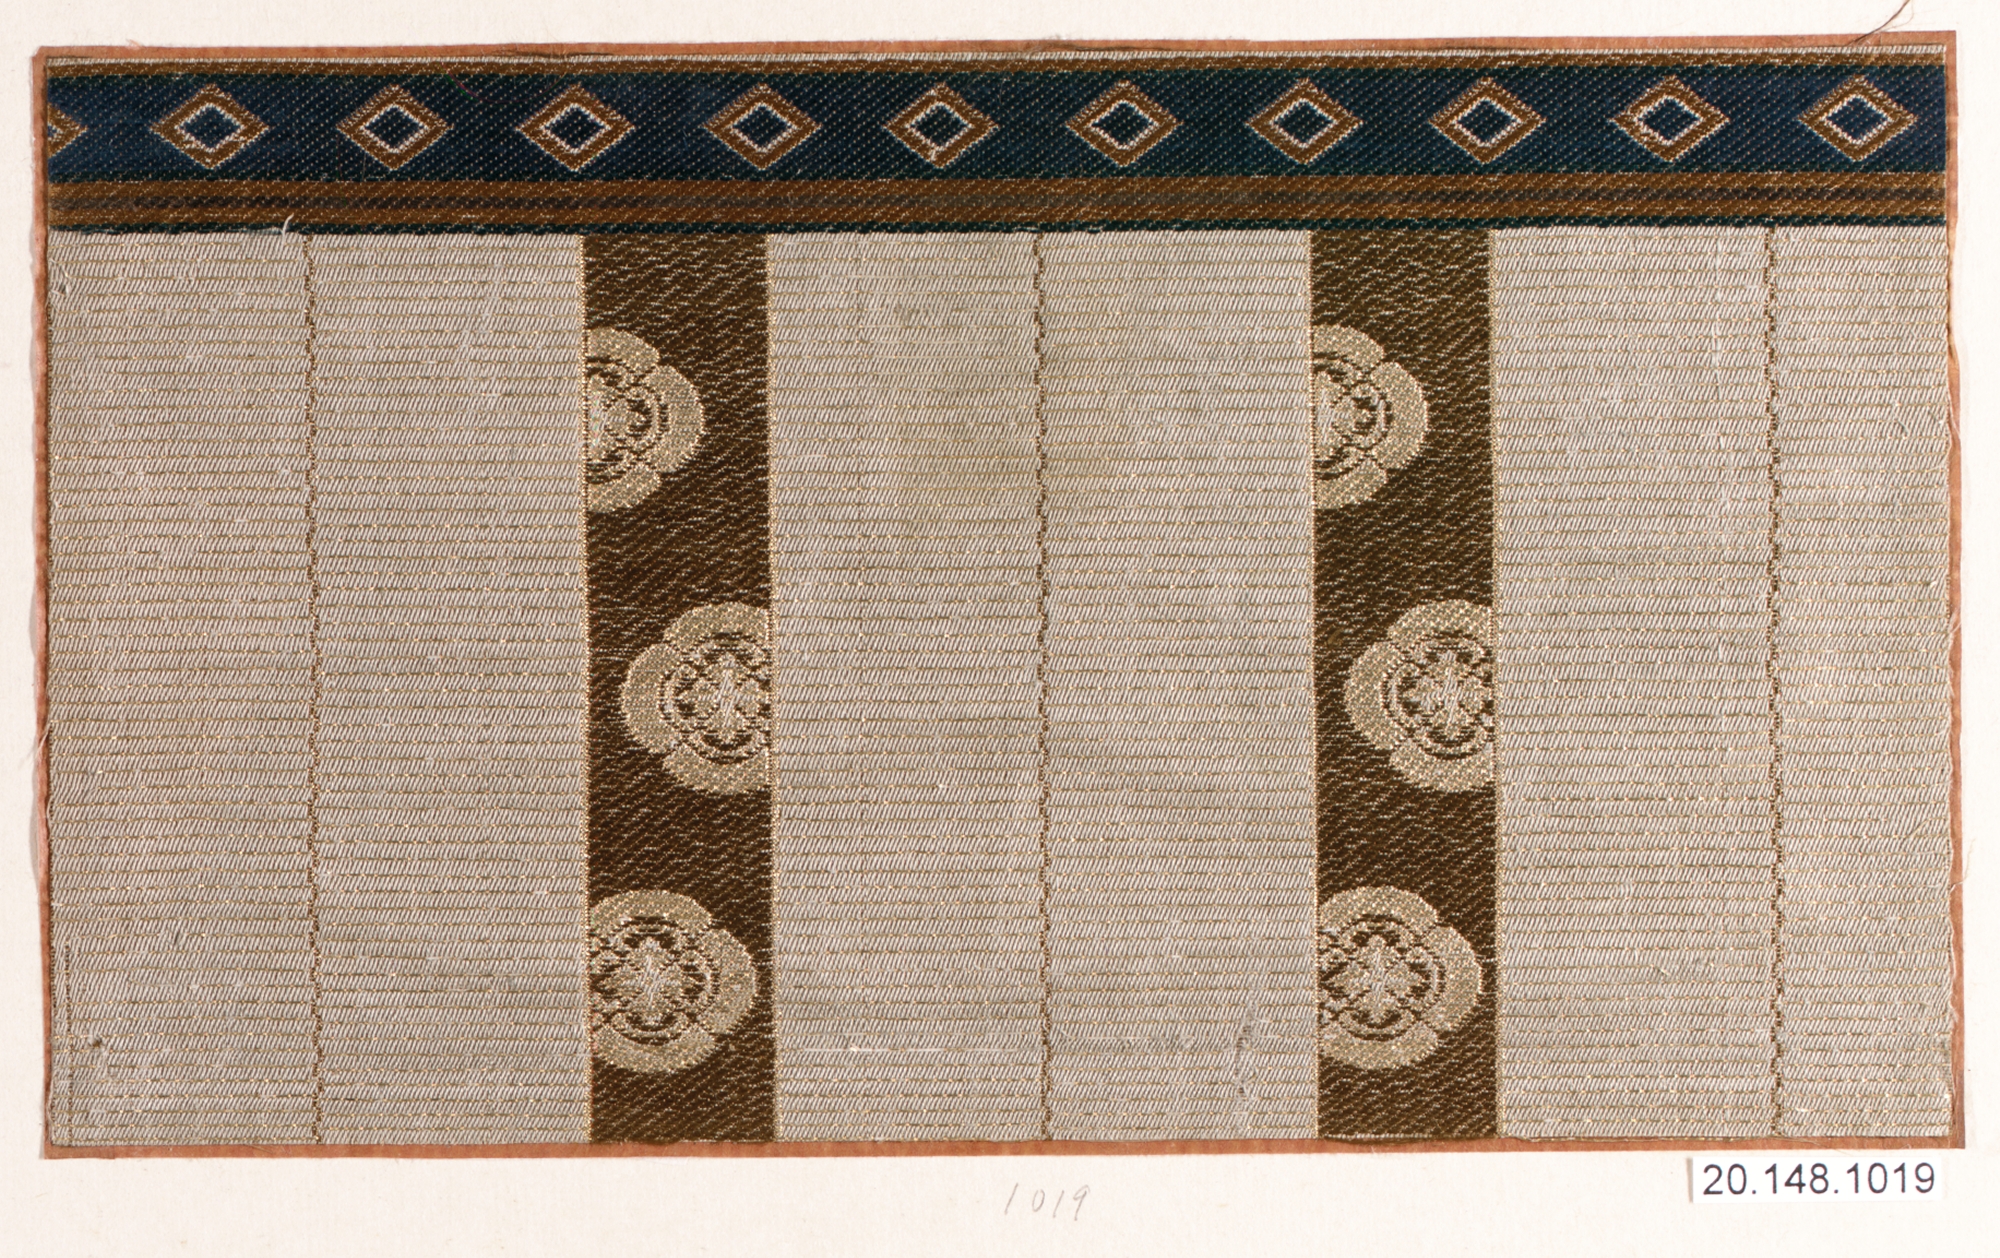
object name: piece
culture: japanese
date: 1701-1800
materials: silk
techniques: compound weave